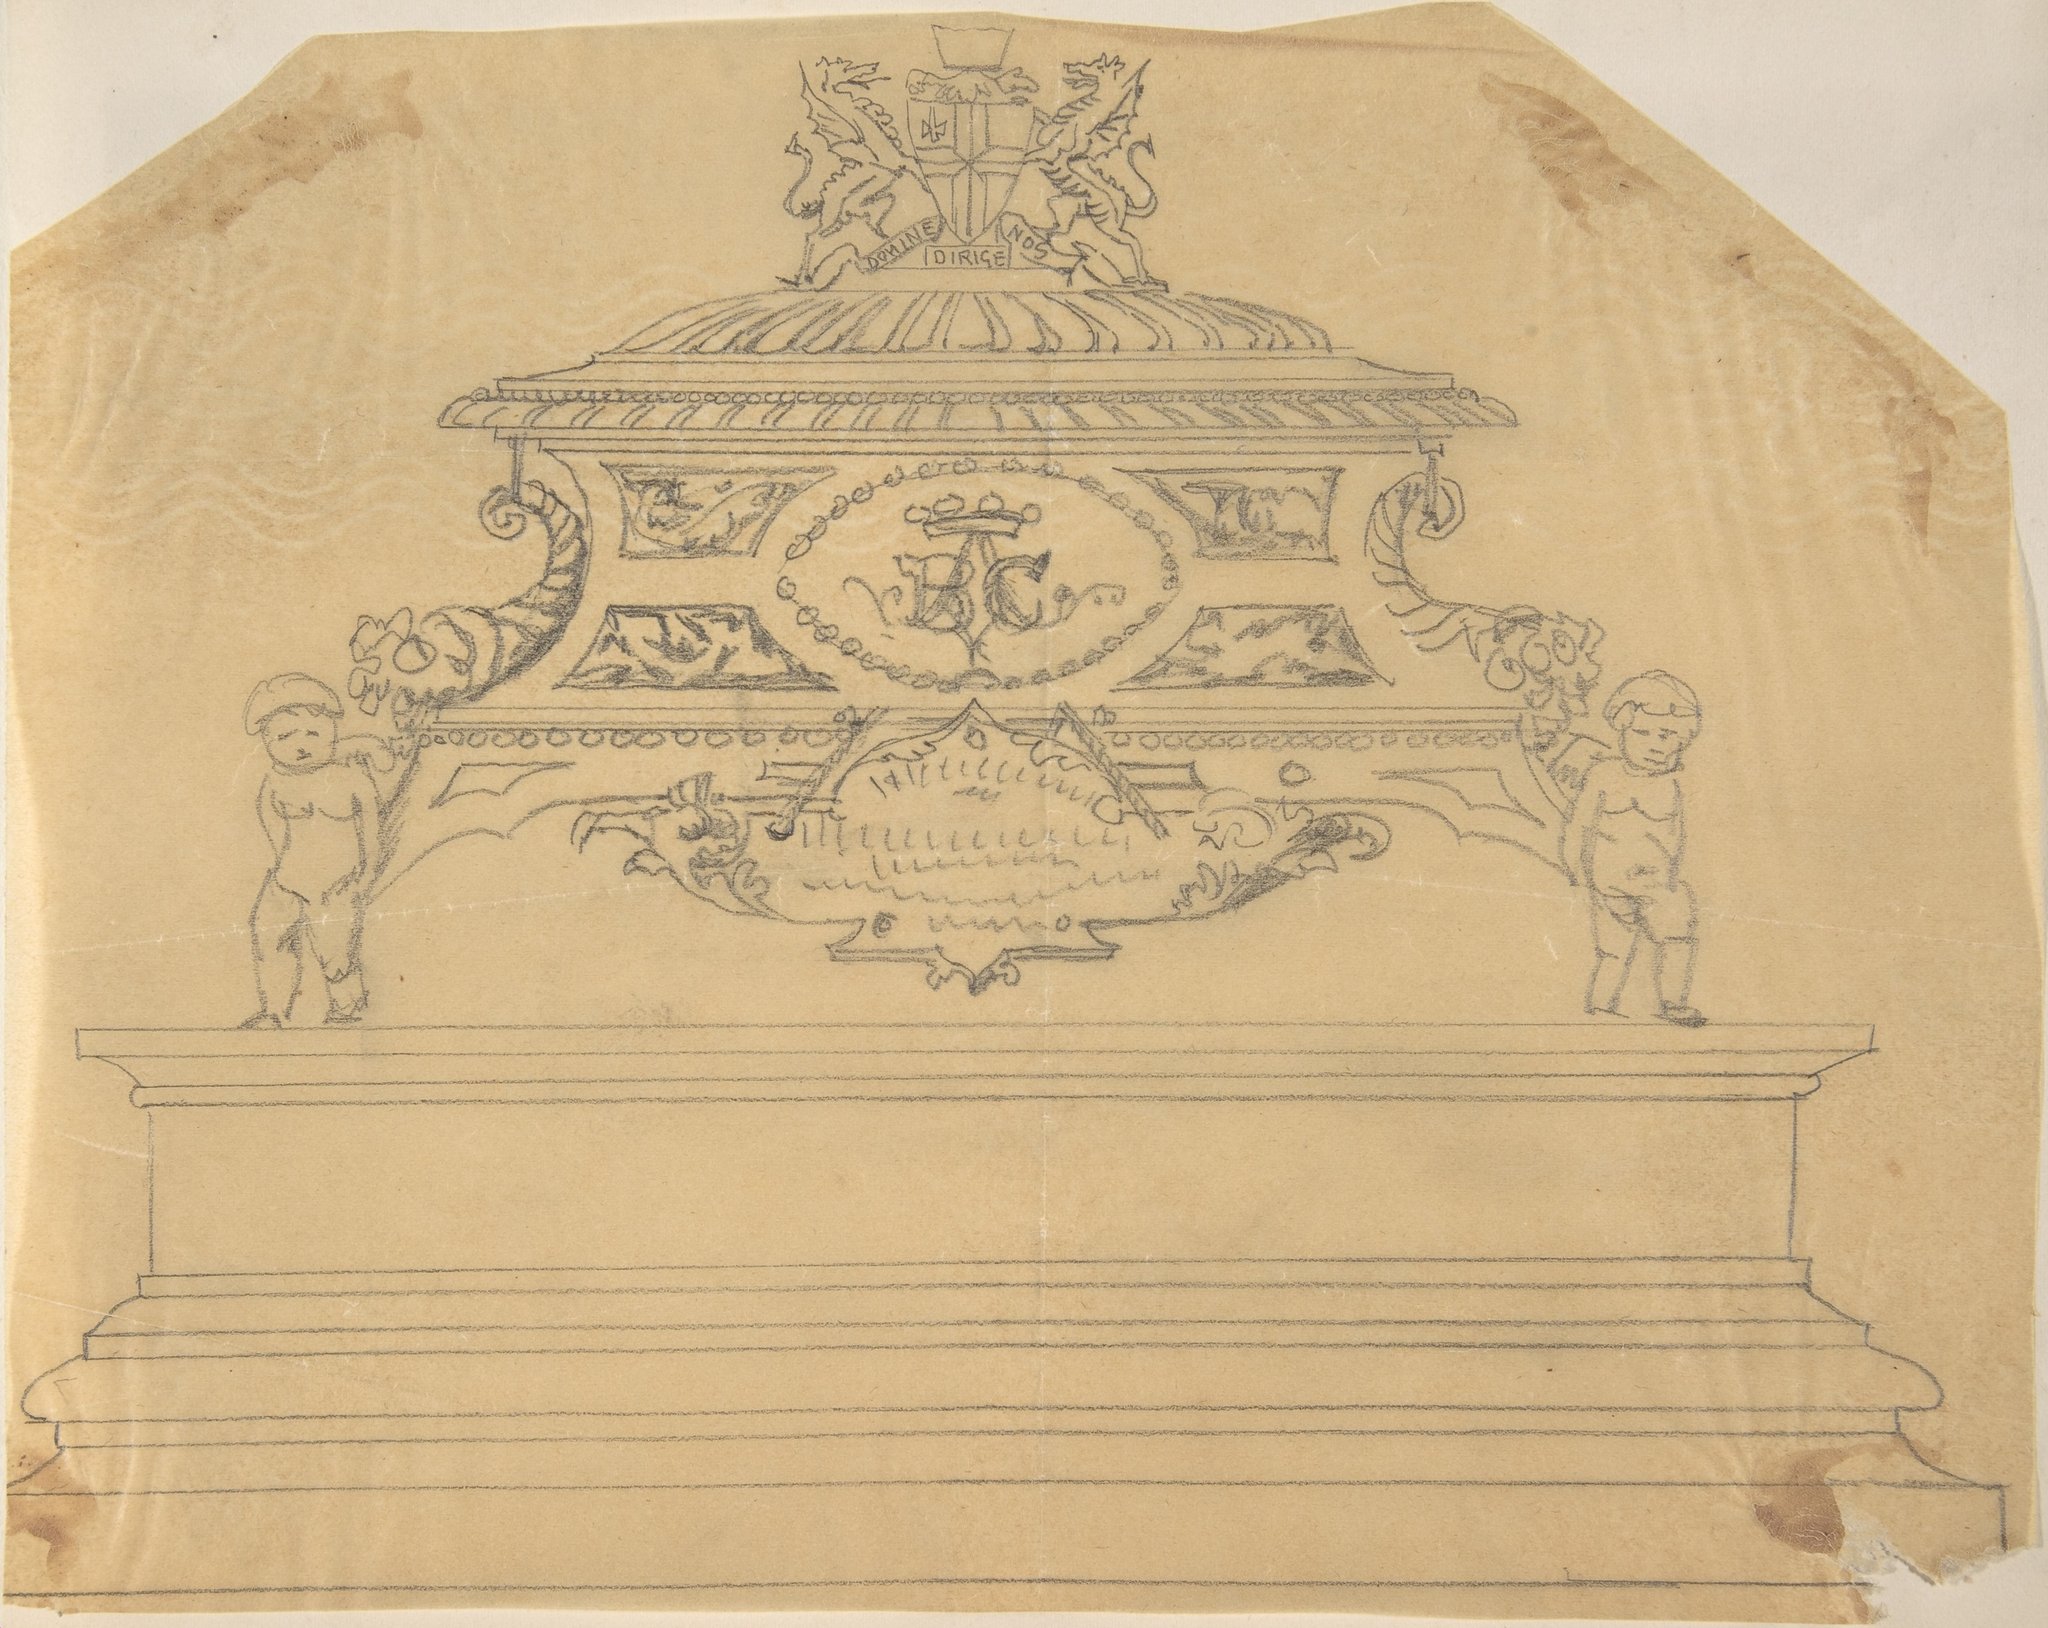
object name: drawing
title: Metal Casket Supported by Putti, inscribed with Crowned Initials B.C., and Topped with Dragons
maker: anonymous, british, 19th century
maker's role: artist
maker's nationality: british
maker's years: 1800-1900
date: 1851-1900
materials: graphite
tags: dragons,putti,coat of arms